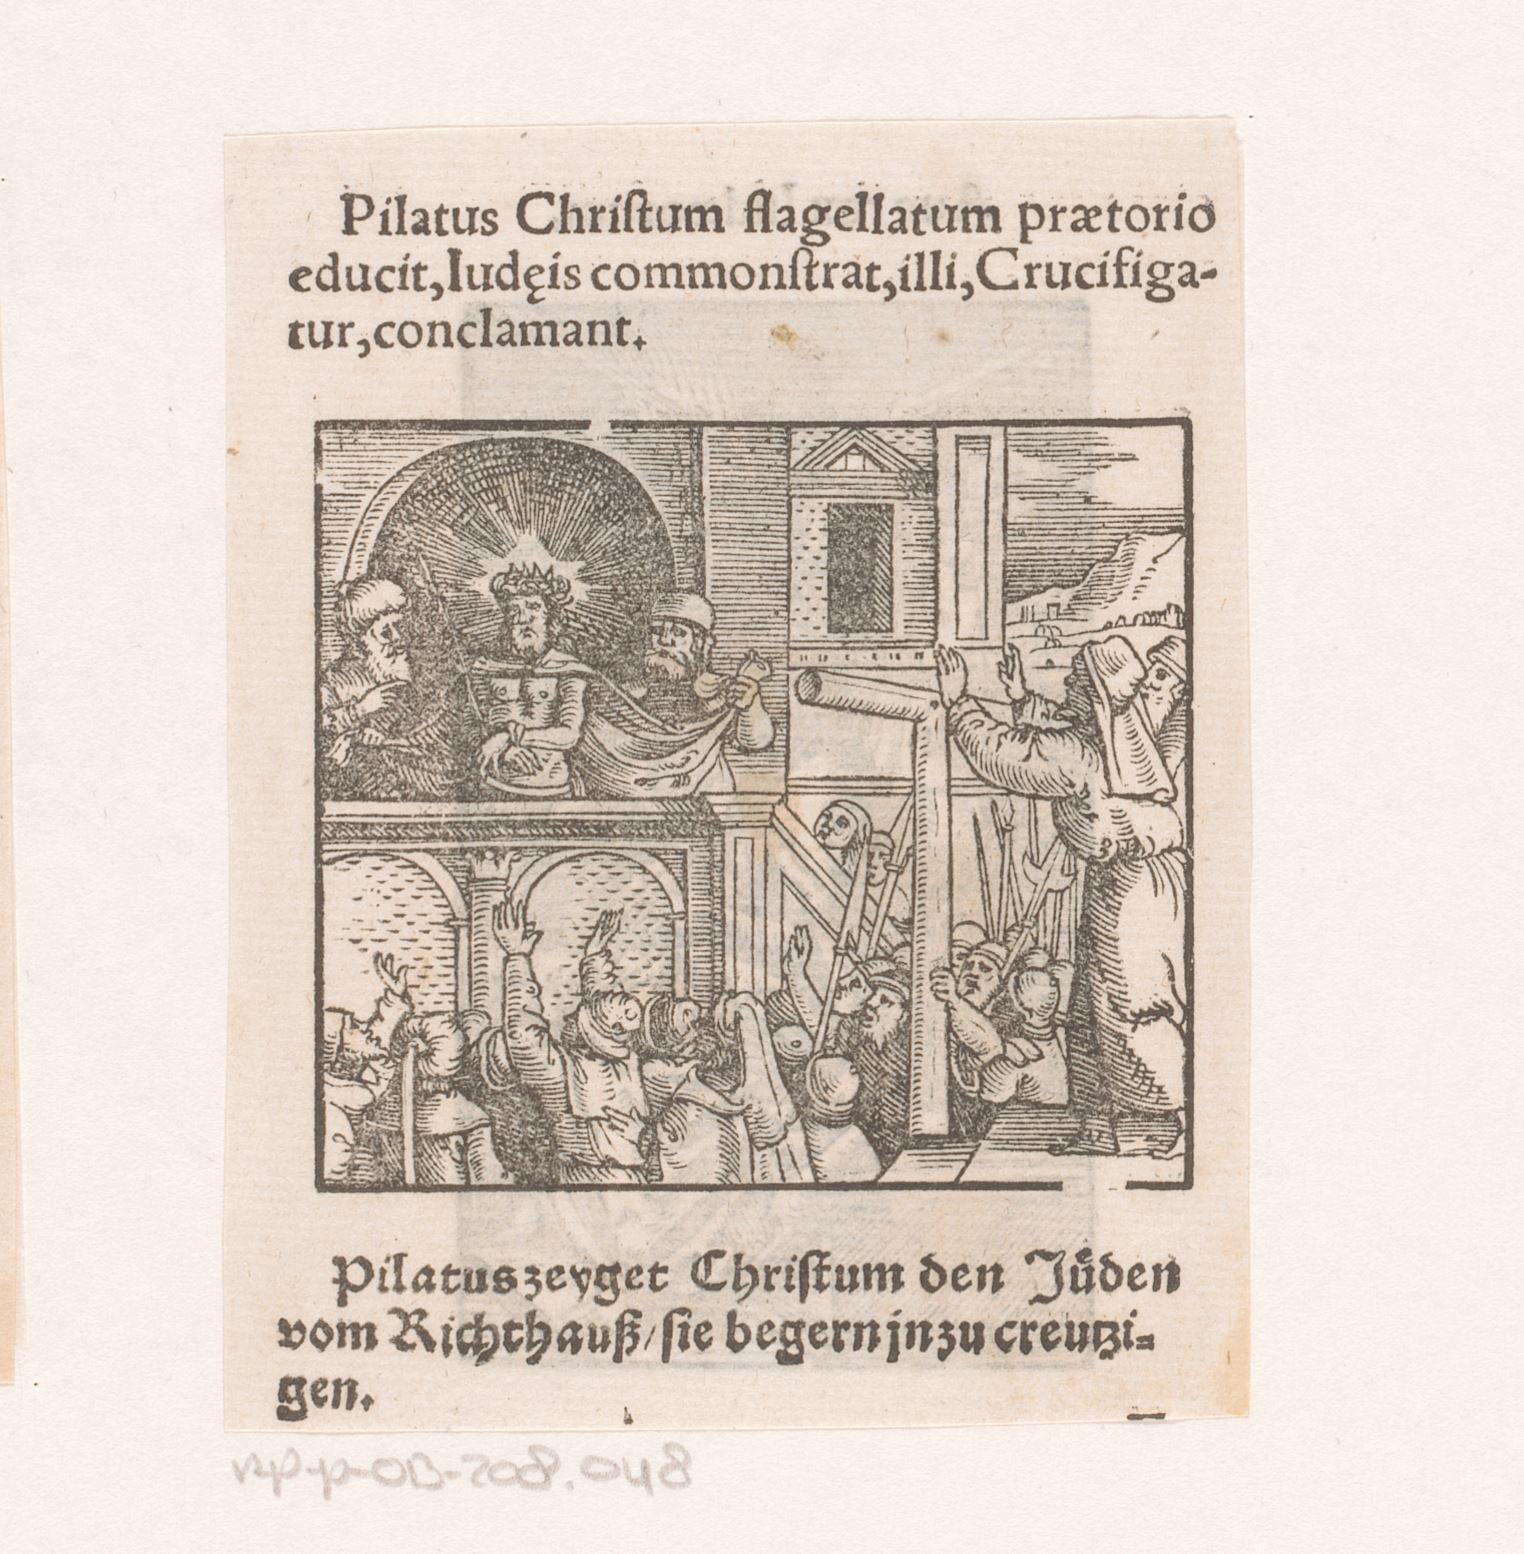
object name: print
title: Christus aan het volk getoond (Ecce Homo)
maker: Anonymous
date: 1600-1699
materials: paper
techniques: letterpress printing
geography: netherlands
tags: pilate showing christ to the people, 'ostentatio christi', 'ecce homo' (john 19:4-6)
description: Christus wordt op een podium aan het volk getoond. Pilatus heeft aan het volk gevraagd of hij Christus of Barabbas zal vrij laten. Het volk roept dat Barabbas moet worden vrijgelaten en dat Christus moet worden gekruisigd.